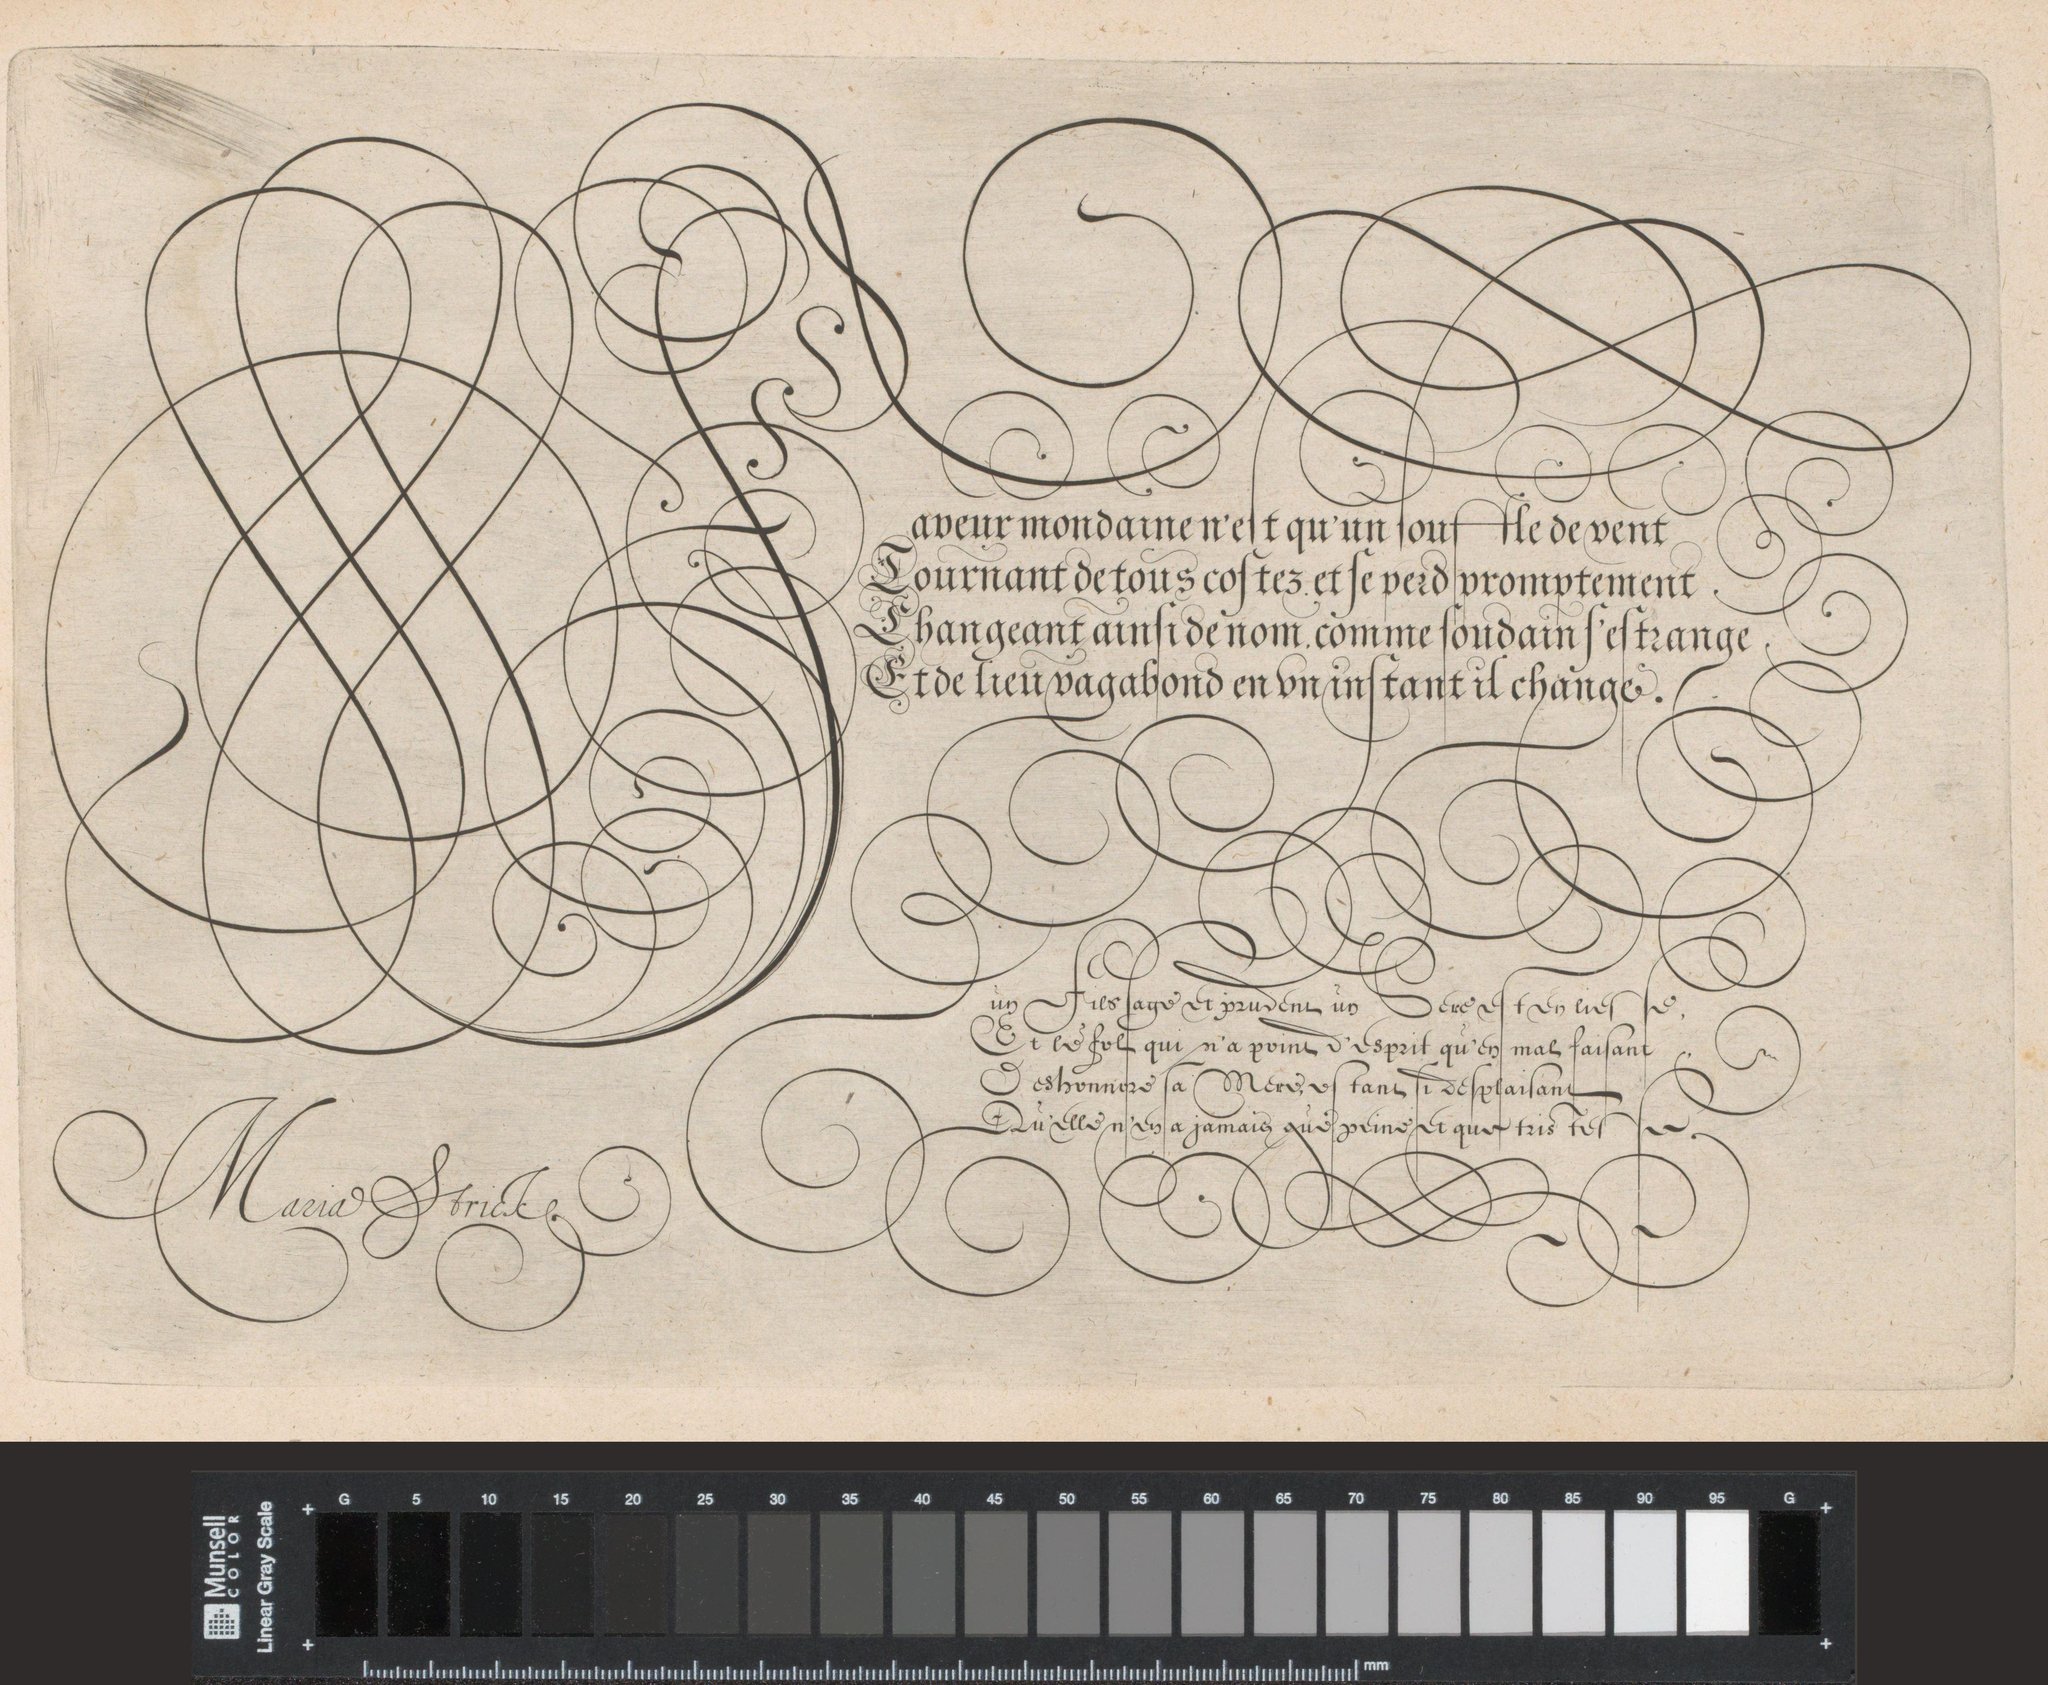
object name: album leaf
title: Schat oft voorbeelt ende verthooninge van verscheyden geschriften (...)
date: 1618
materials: paper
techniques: engraving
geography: rotterdam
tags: calligraphy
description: Schrijfvoorbeeld in het Frans met kapitaal F en twee keer vier regels tekst: Faveur mondaine (...). Omlijst door kalligrafisch krulwerk. De prent maakt deel uit van een album.